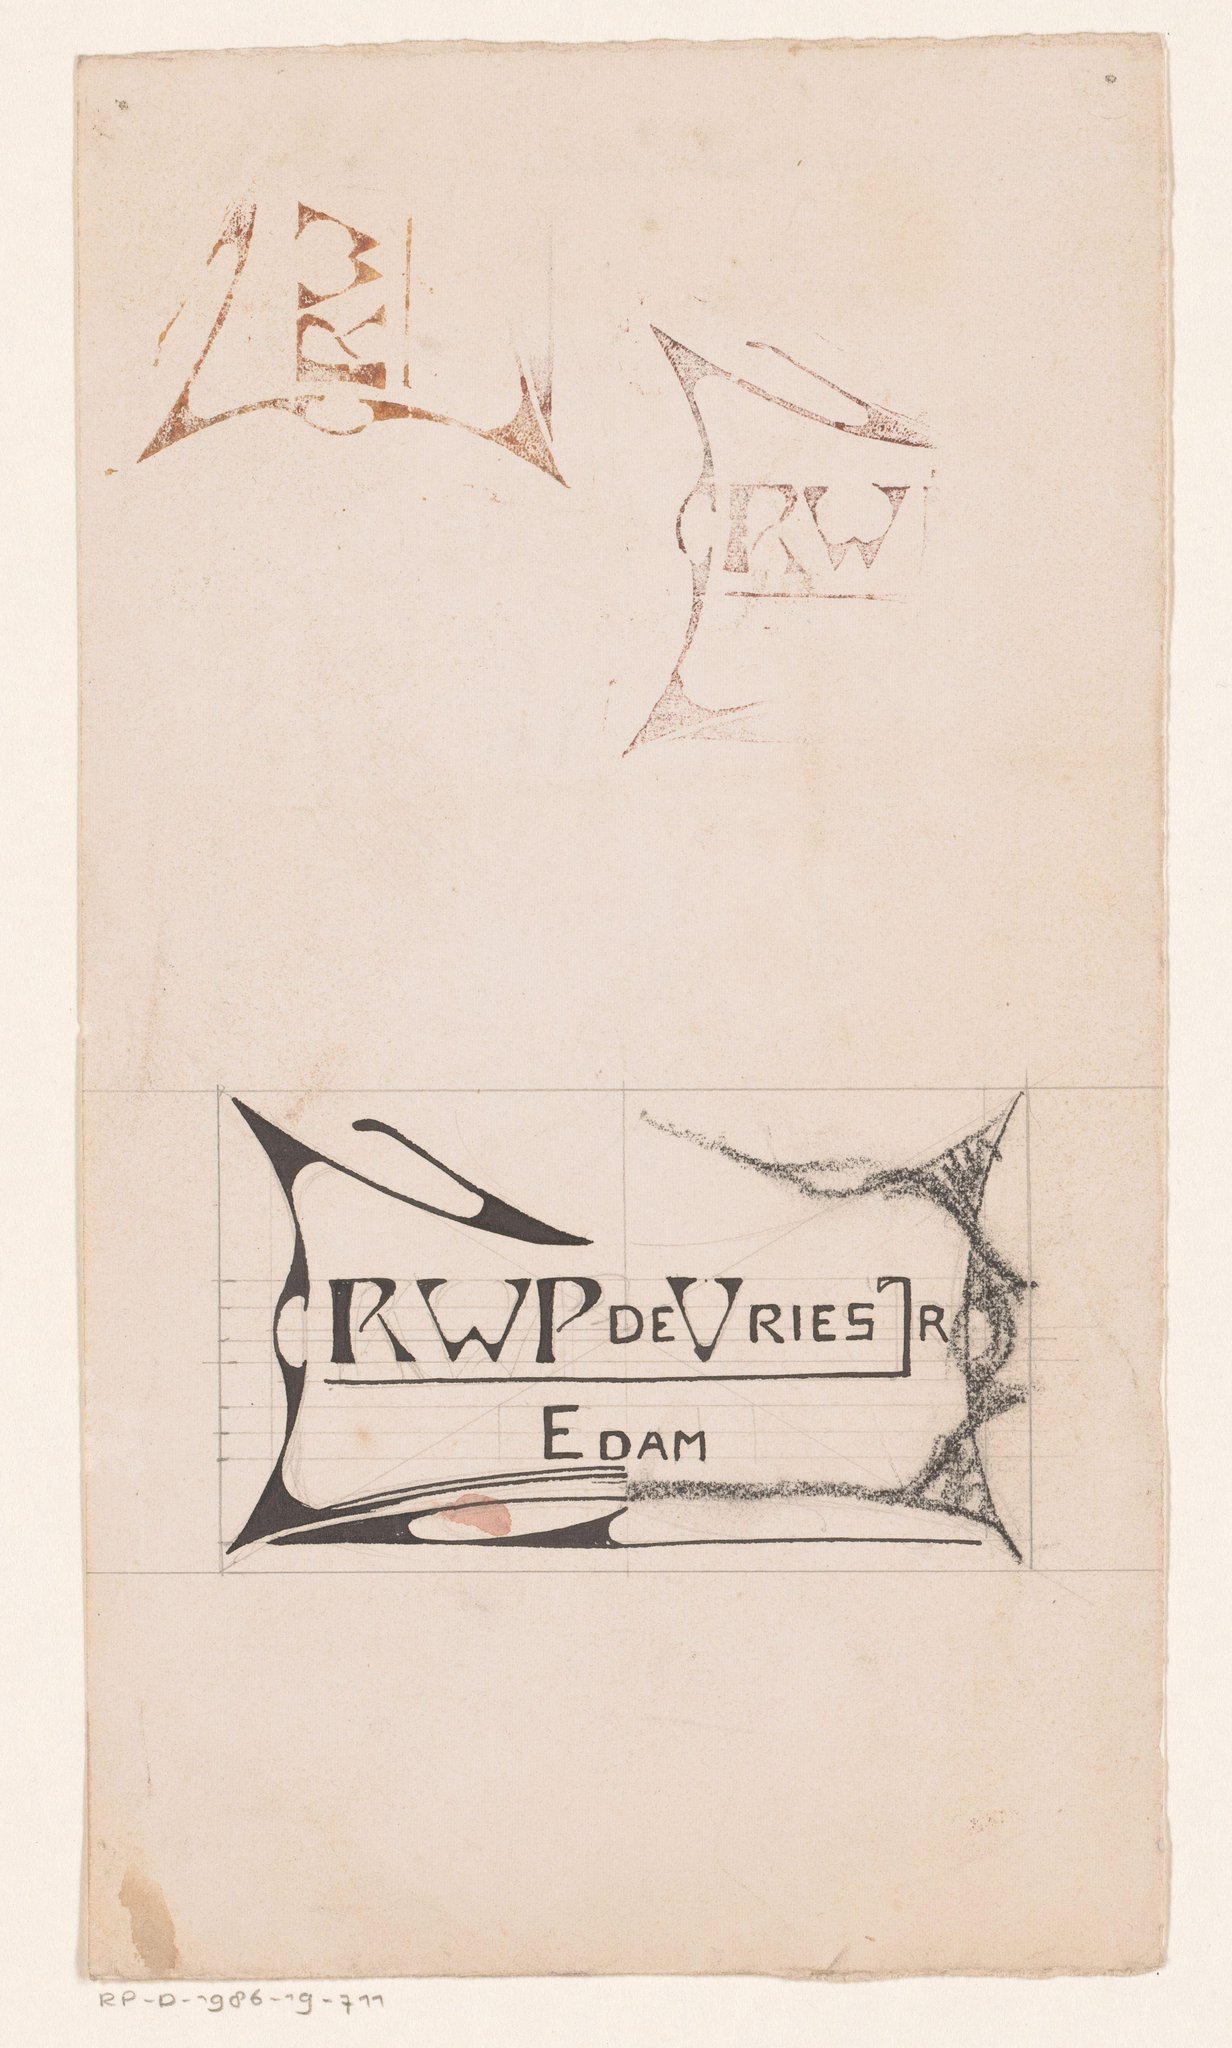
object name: drawing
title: Ontwerp voor vignet R.W.P. de Vries Jr. Edam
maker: reinier willem petrus de vries (1874-1953)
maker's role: draughtsman, print maker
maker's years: 1874-1953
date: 1884-1952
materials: chalk, ink, paper, pencil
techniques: pen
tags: amsterdam, print maker, reinier willem petrus de vries (1874-1953)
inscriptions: collector's mark: ‘R:MVS.’